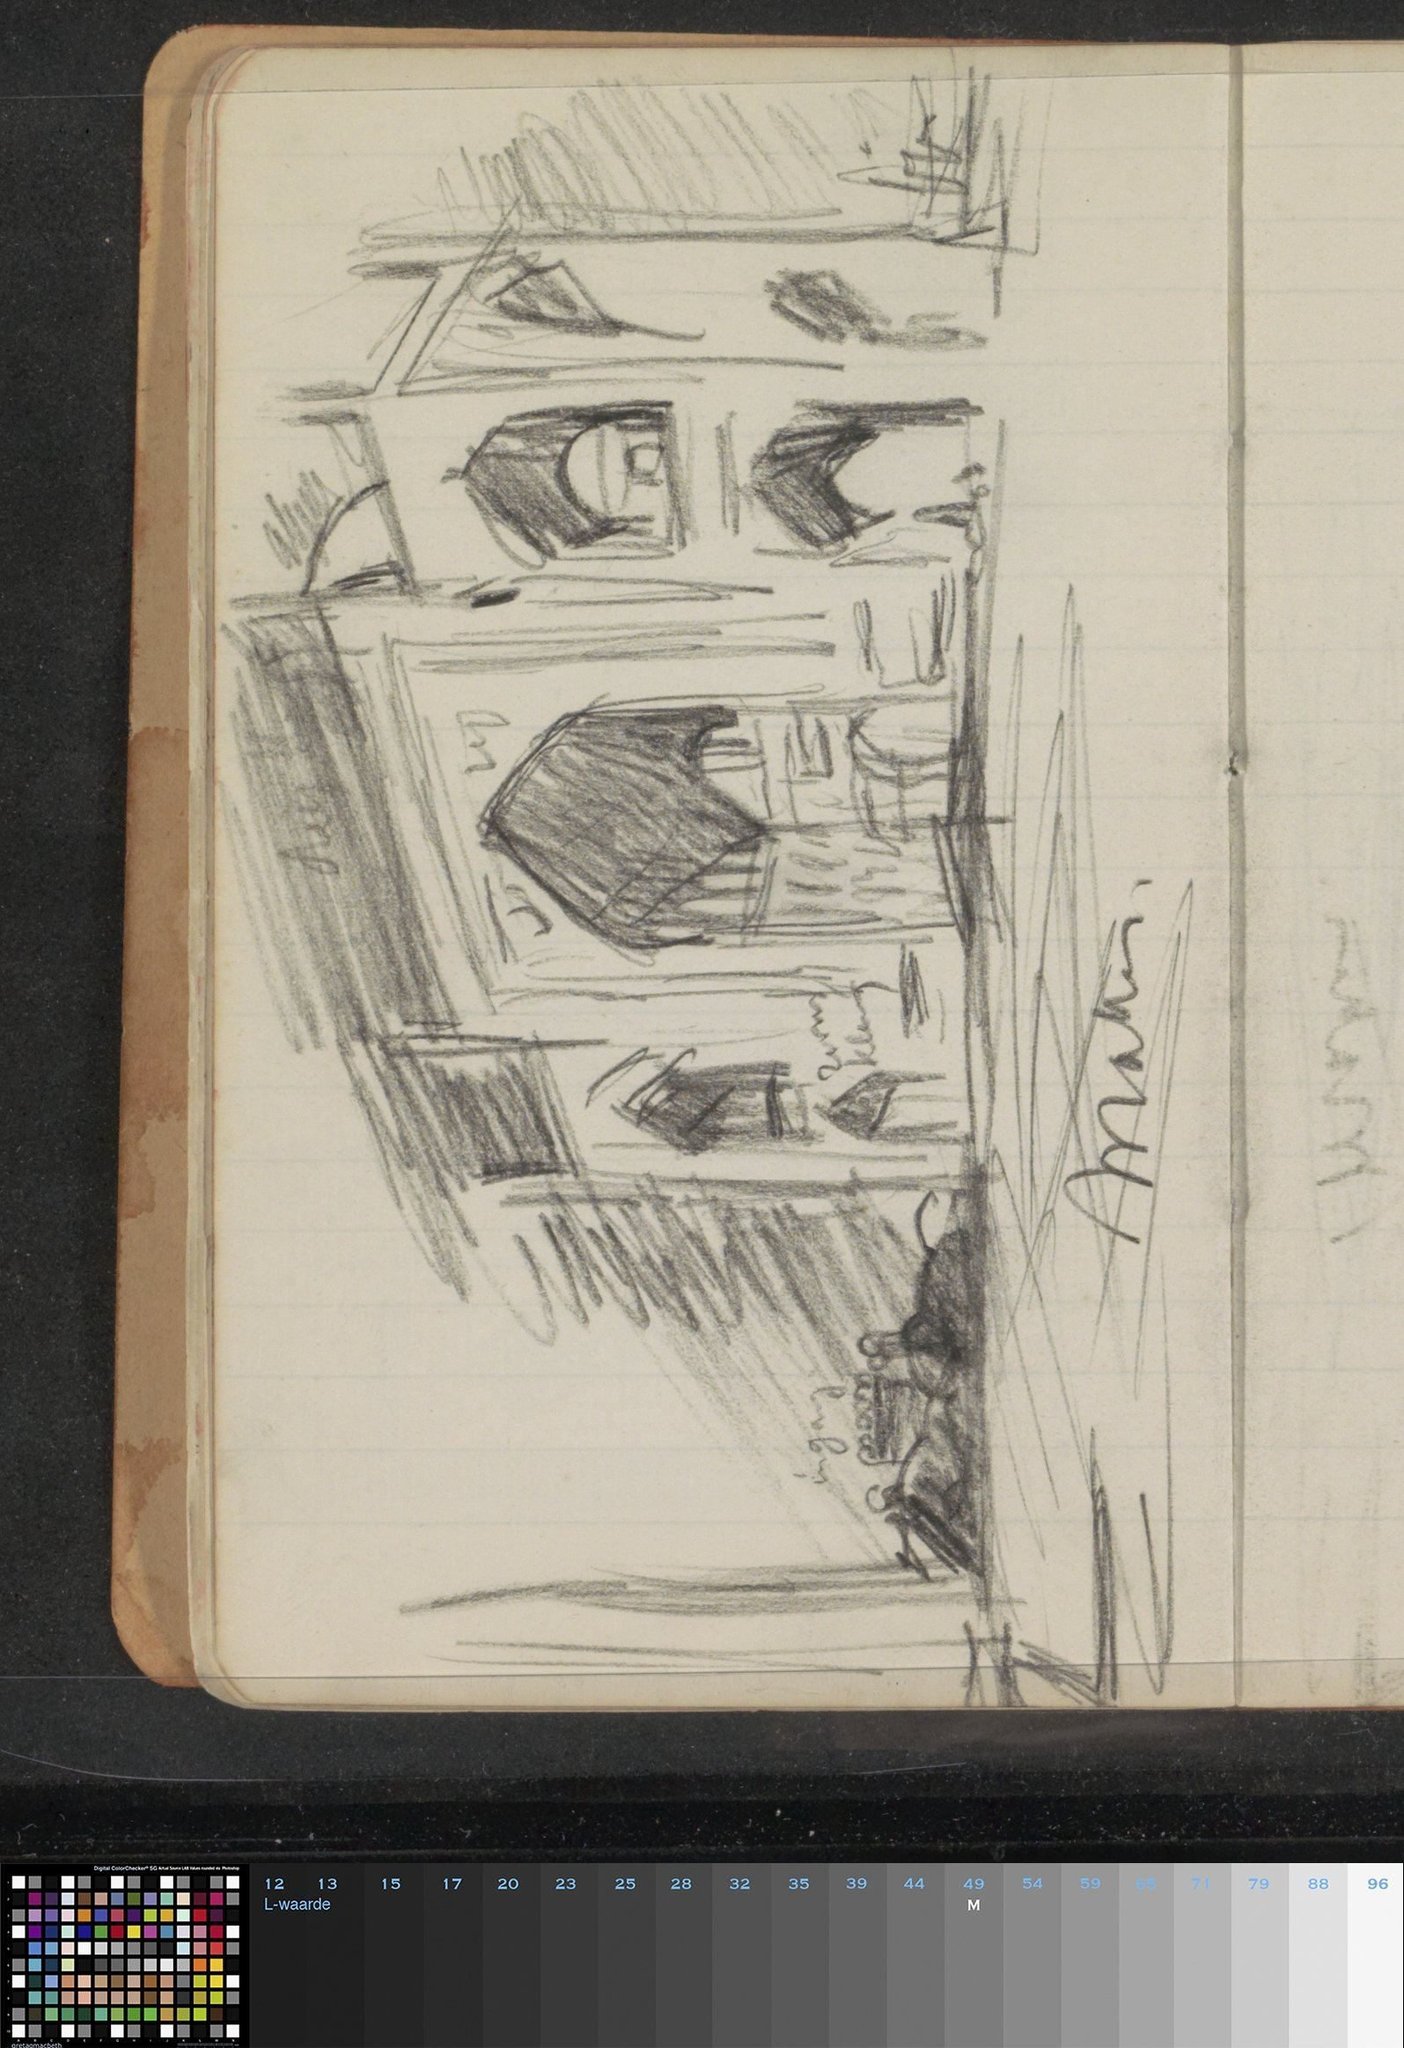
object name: sketchbook leaf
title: Zijaanzicht van de Taj Mahal, met uitzicht op de toegangspoort Darwaza-i rauza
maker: marius bauer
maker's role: draughtsman, print maker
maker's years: 1867-1932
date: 1897-1898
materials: chalk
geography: agra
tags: mausoleum, gate, entrance, exterior ~ representation of a building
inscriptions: annotation: ‘ingang/ Mahal.’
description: Pagina 48 uit een schetsboek met 36 bladen.